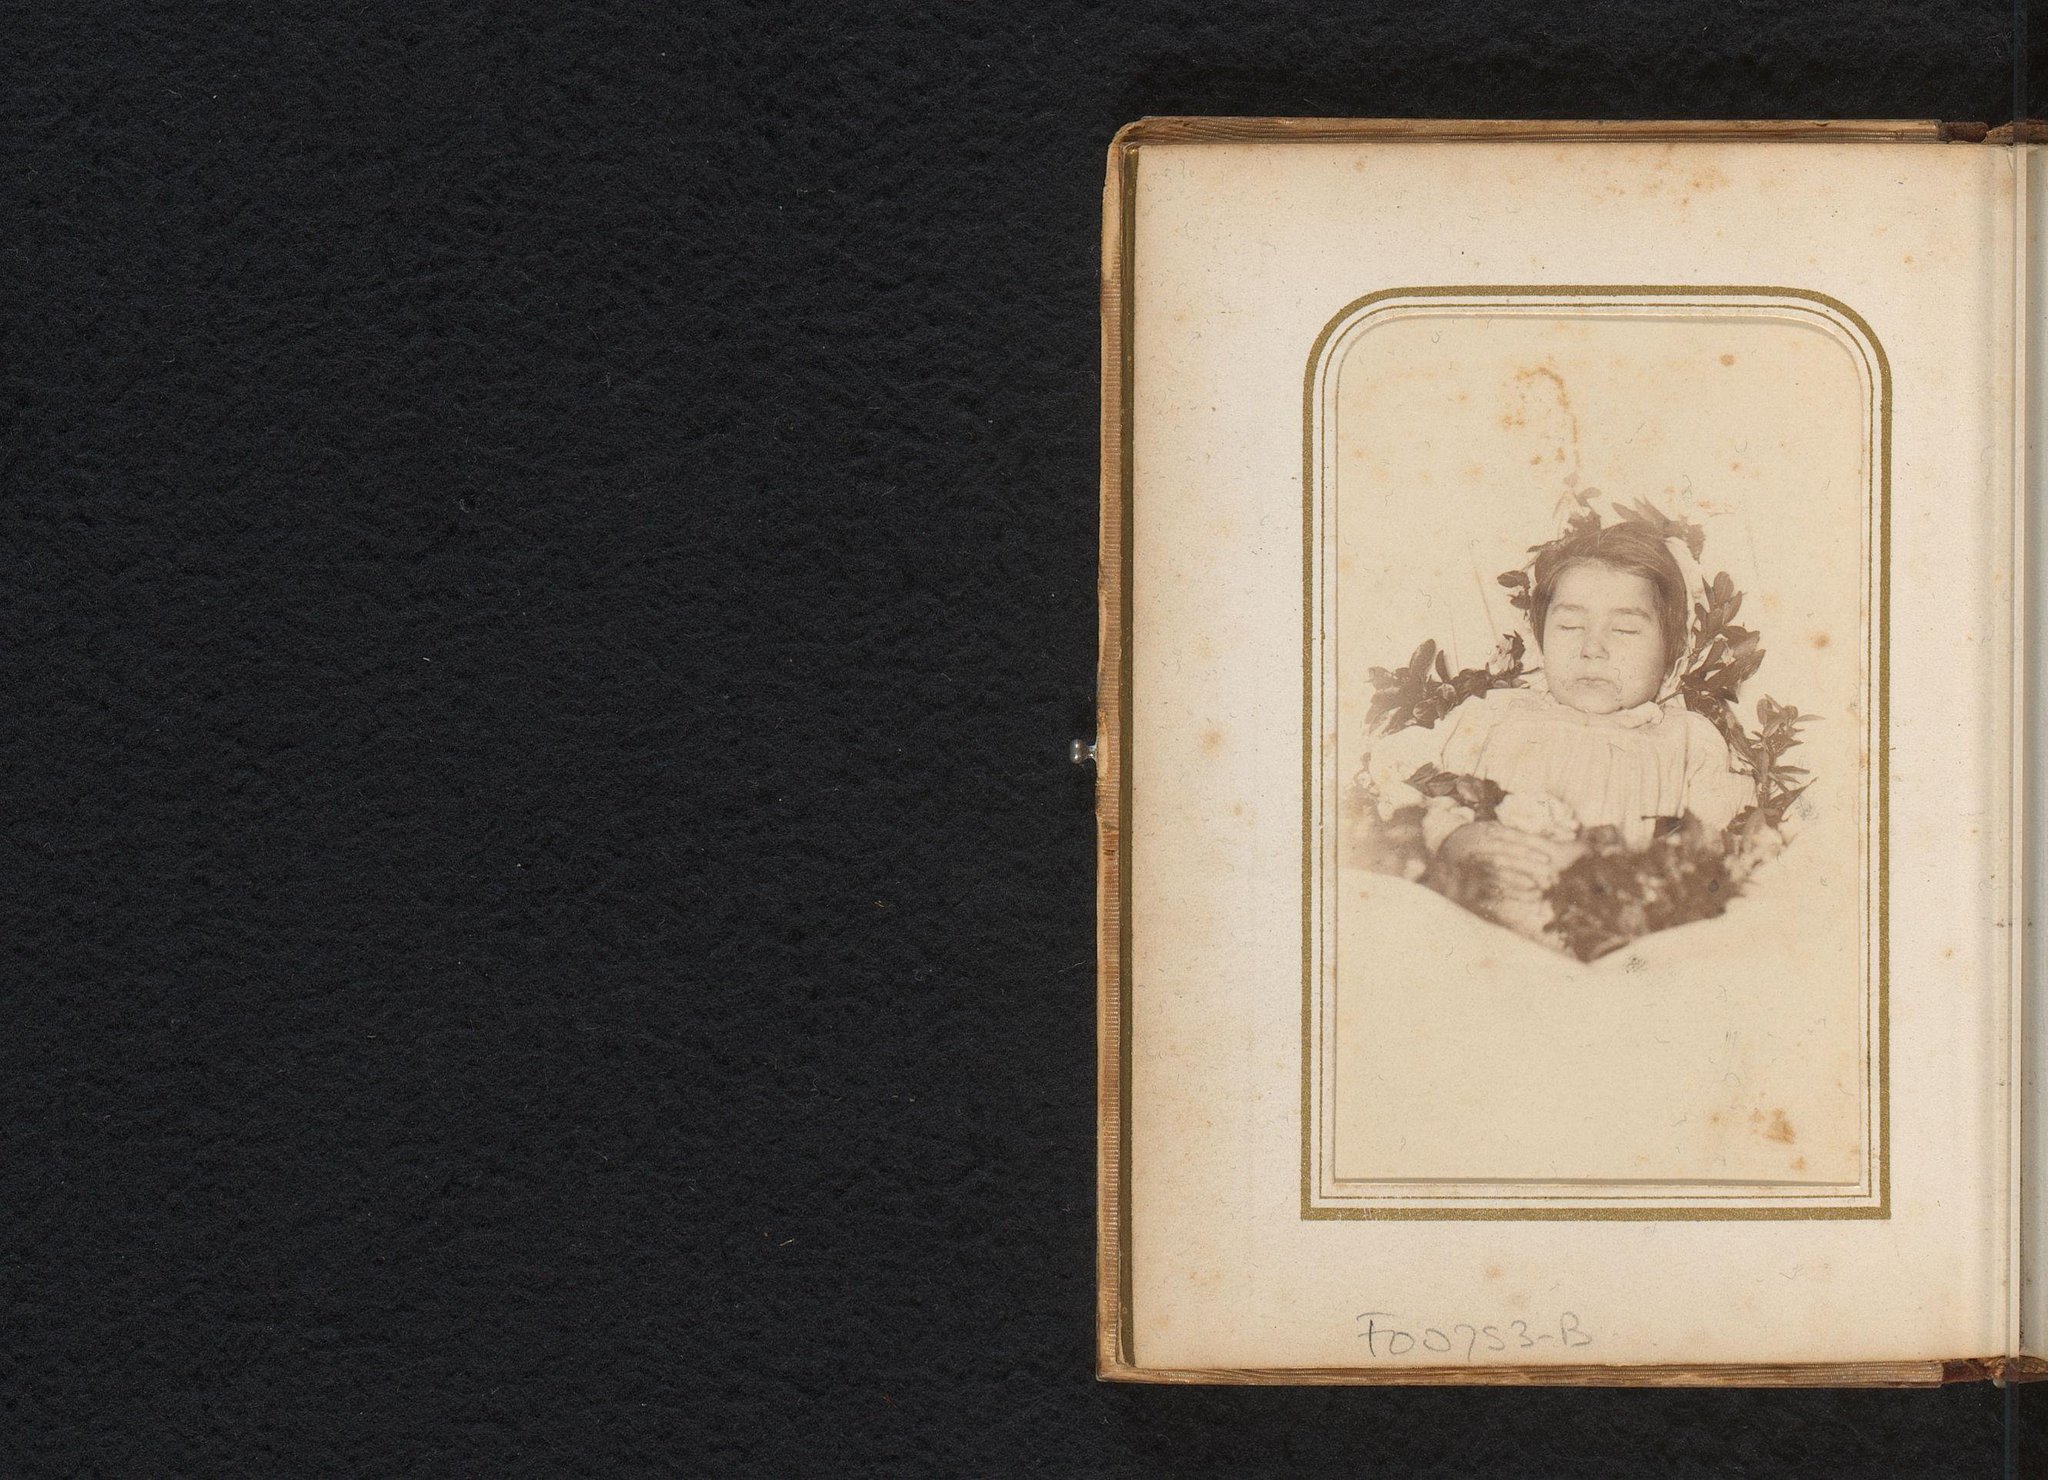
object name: photograph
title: Post-mortemportret van een kind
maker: jacobus van gorkom (jr.)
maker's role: print maker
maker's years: 1827-1880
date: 1855-1879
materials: cardboard, photographic support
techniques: albumen print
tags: child, the corpse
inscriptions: inscription: ‘J. van Gorkum jr./ Photographe/ Rotterdam/ Kruiskade/ Wyk 14 No. 592’